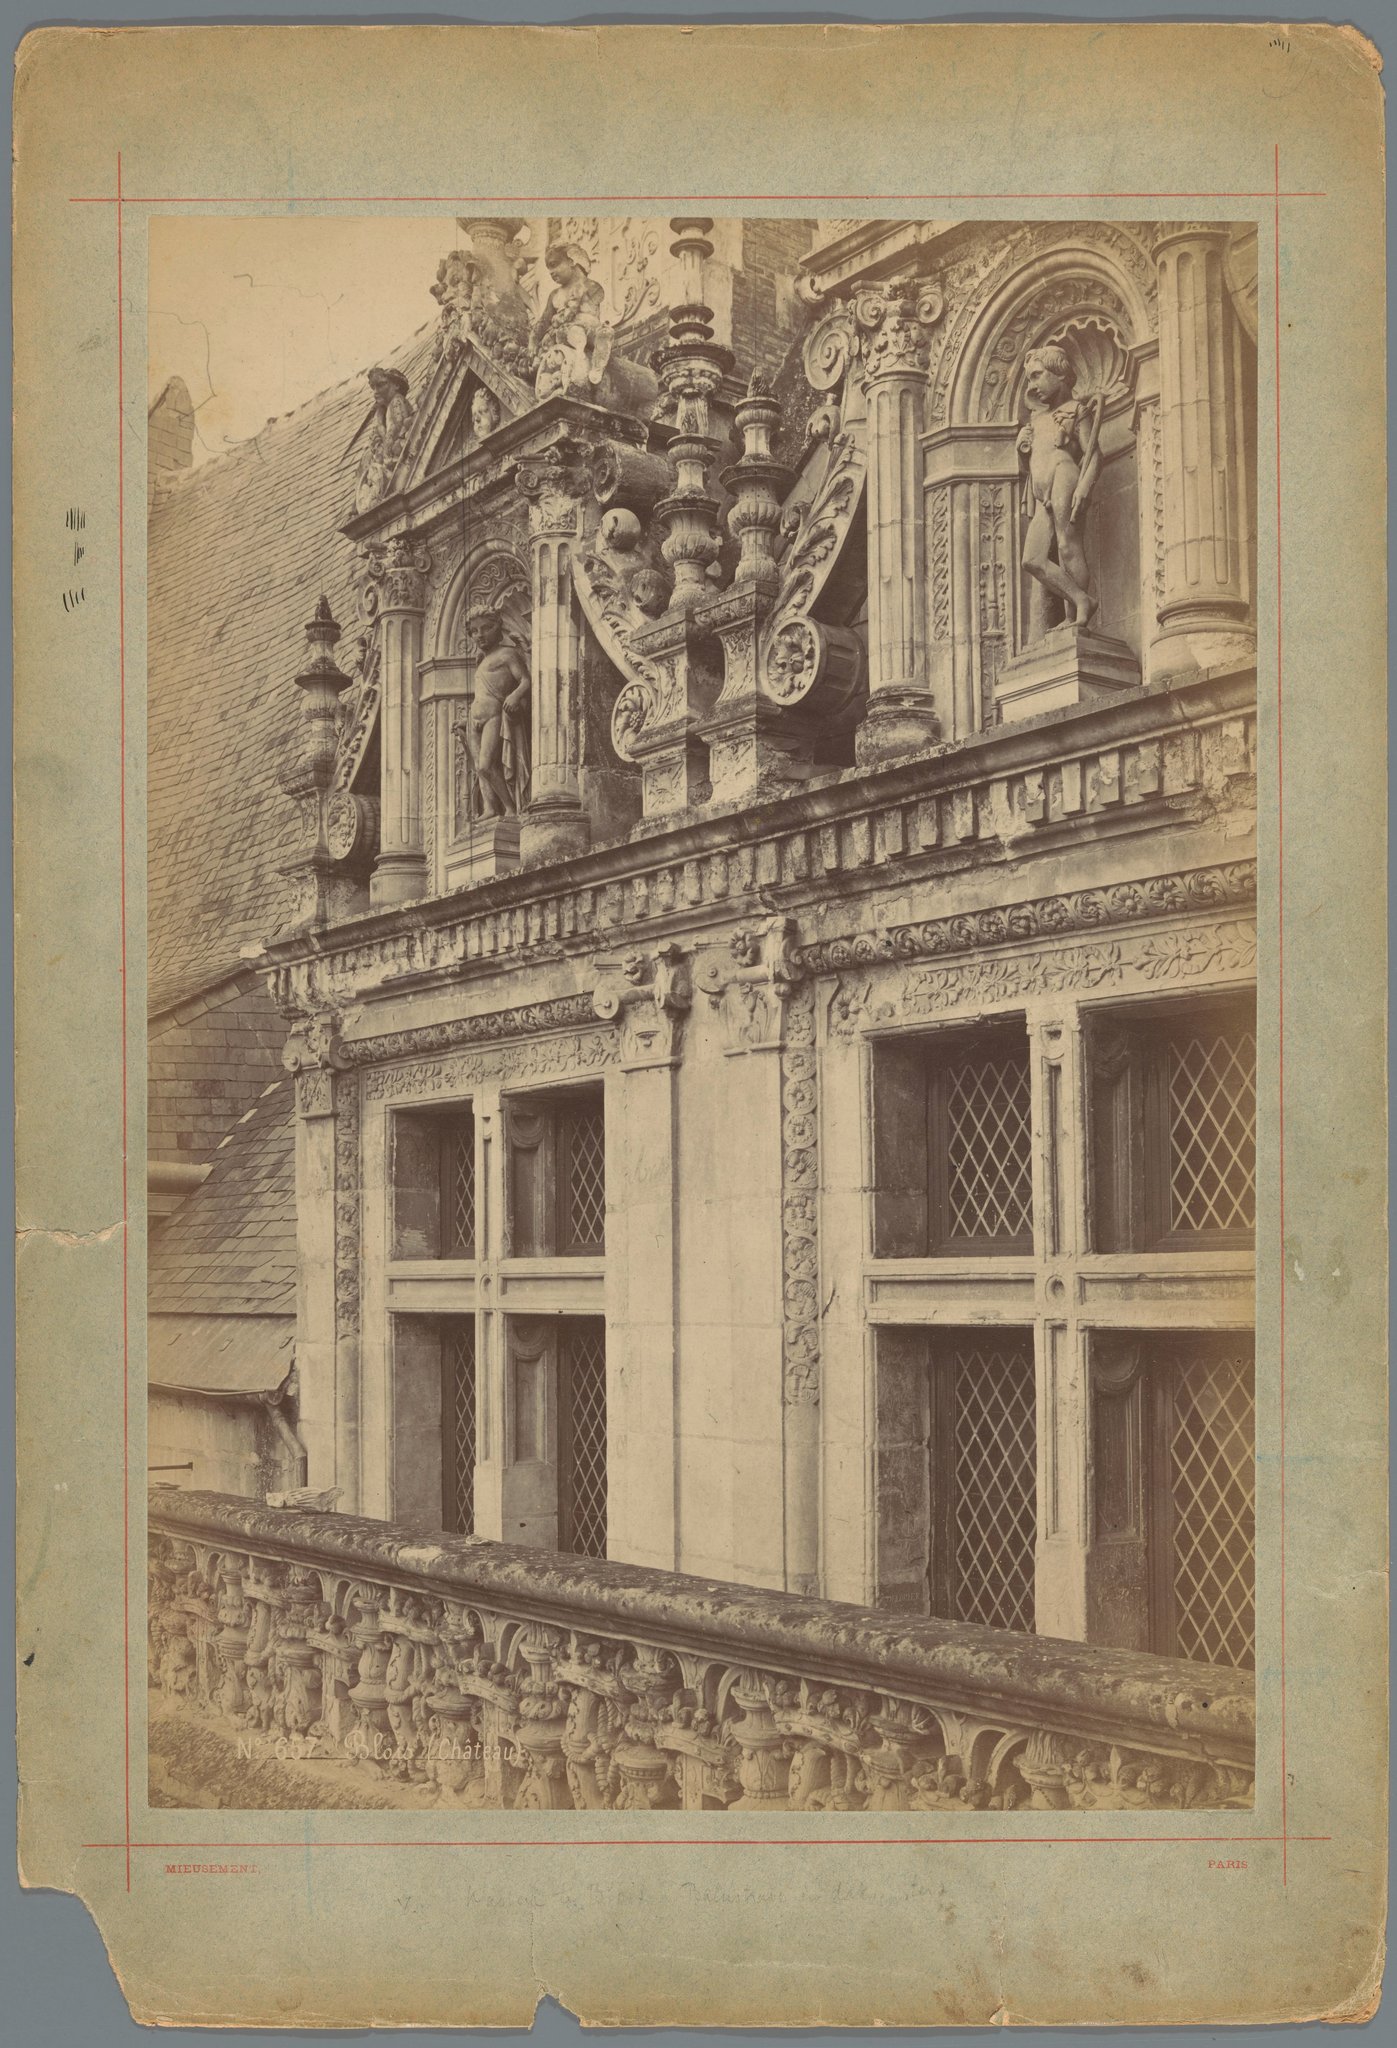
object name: photograph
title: Dakvensters van het Kasteel van Blois geornamenteerd met een fronton en een nis met daarin een sculptuur van een jongen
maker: séraphin-médéric mieusement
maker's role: fotograaf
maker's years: 1840-1905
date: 1875-1900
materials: cardboard, photographic support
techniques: albumen print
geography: blois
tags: other architectural details (with name), piece of sculpture, reproduction of a piece of sculpture, ornament derived from plant forms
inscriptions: number: ‘No. 657’, name: ‘Monsters worden door de Representant J. A. G. de Leur den Haag op franco aanvrage verzonden’, collector's mark: Lugt 3937